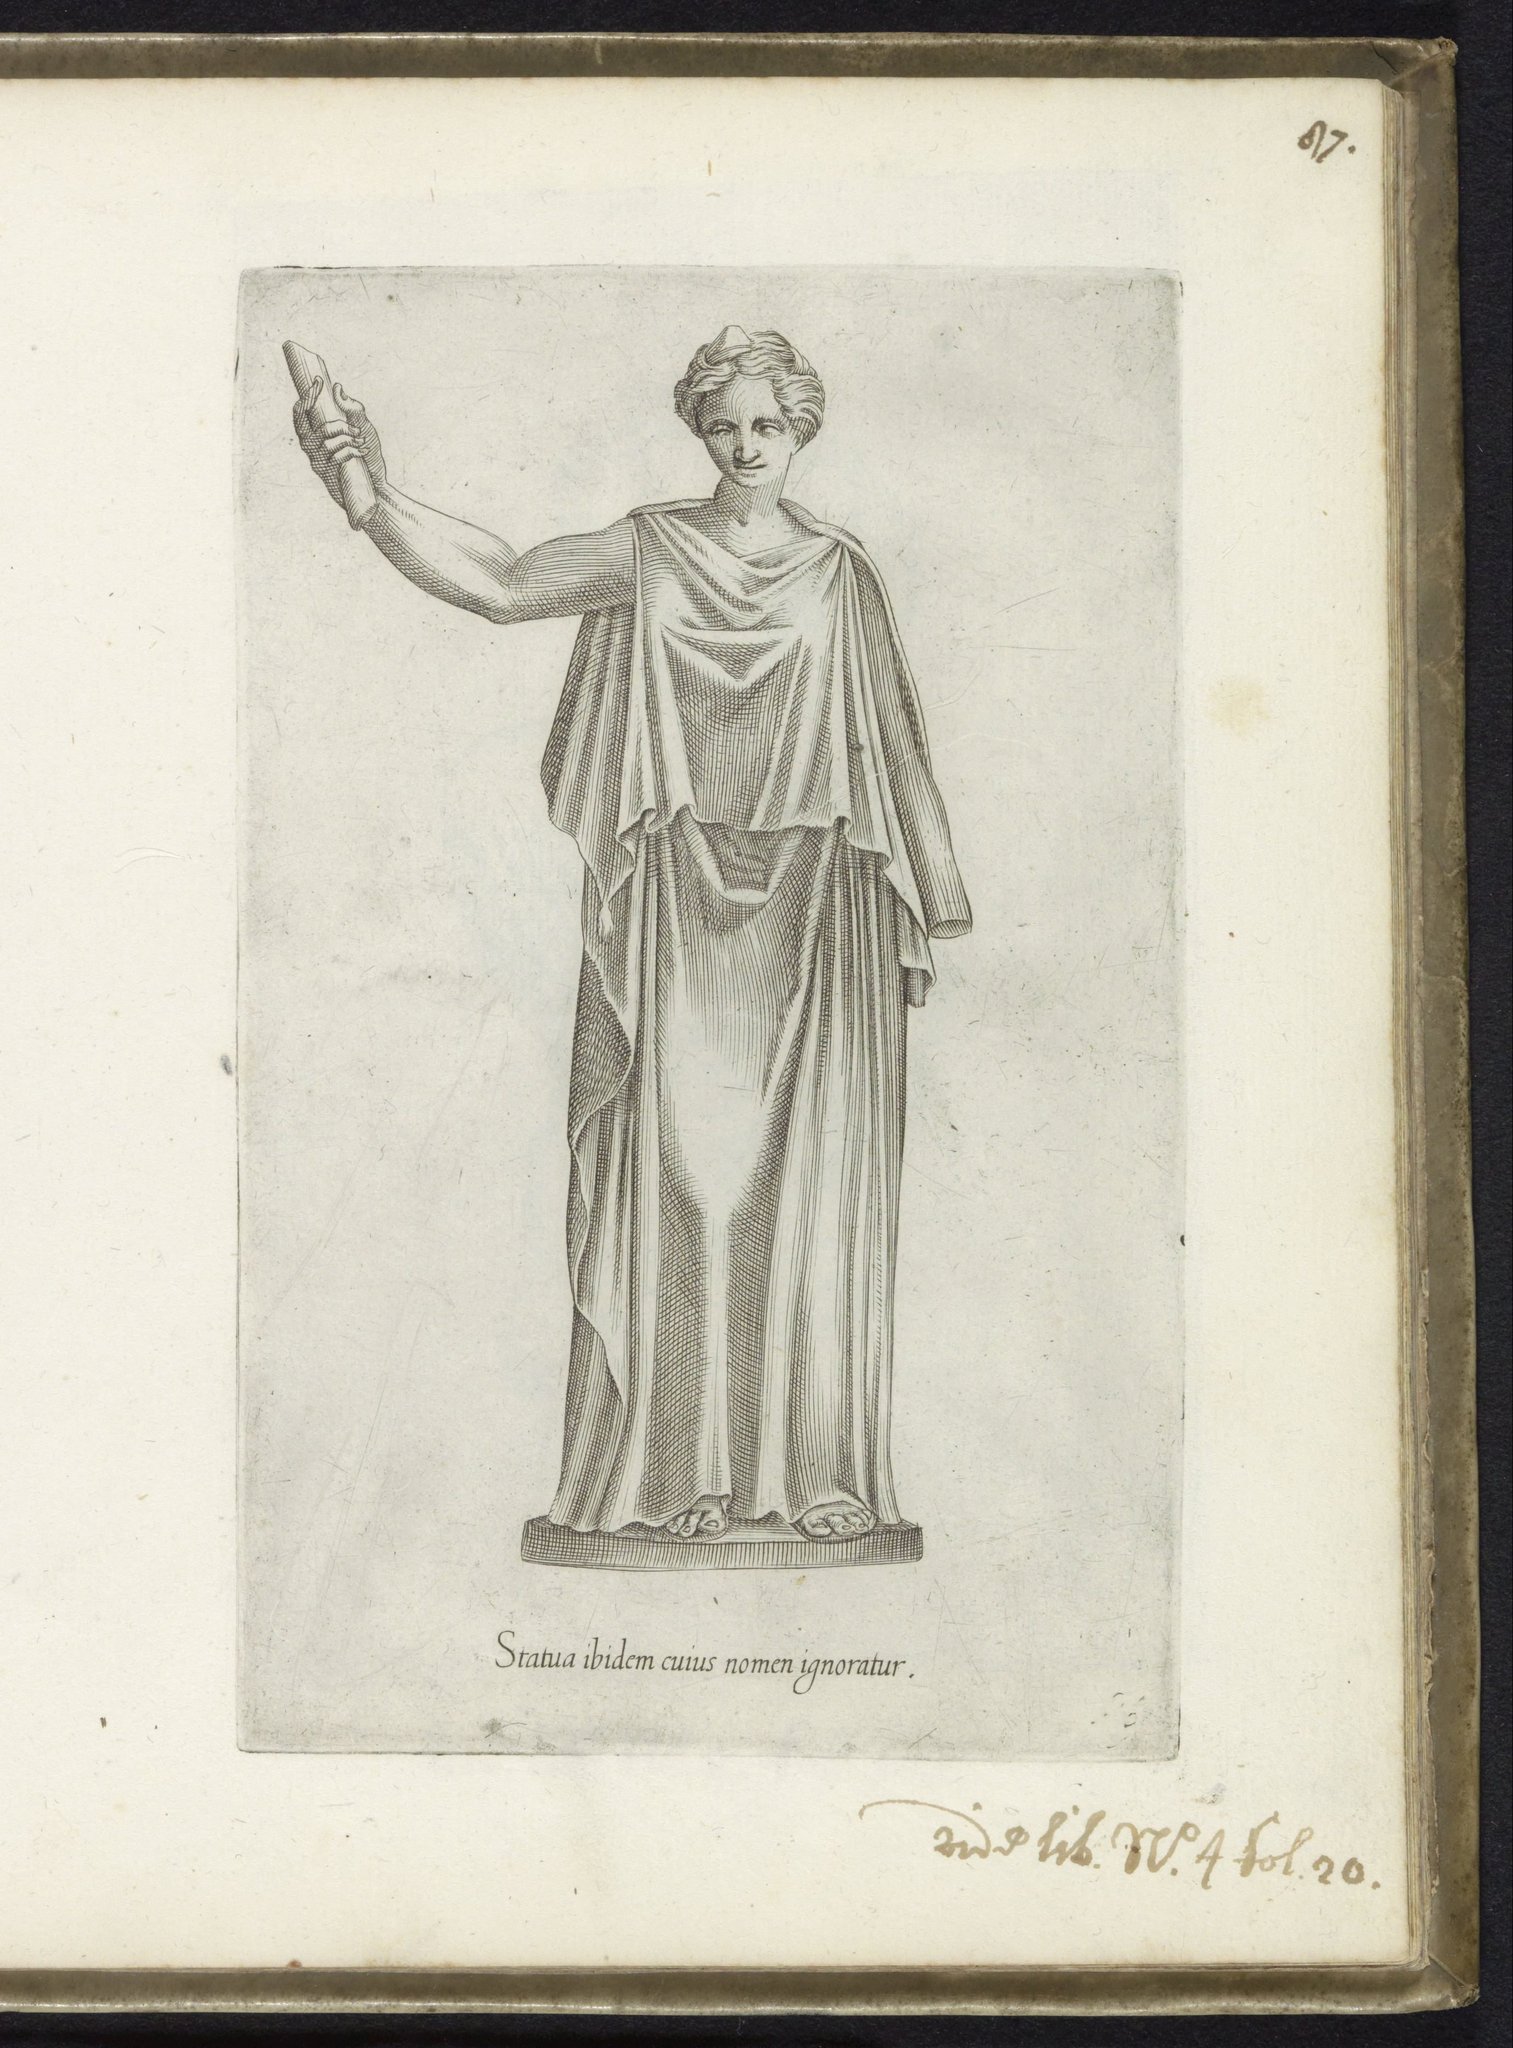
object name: album leaf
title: Sculpturen uit de oudheid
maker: Anonymous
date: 1600-1699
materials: paper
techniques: engraving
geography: italy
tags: adult woman, piece of sculpture, reproduction of a piece of sculpture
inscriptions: inscription: ‘Ende lib. No. 4 fol. 20.’, inscription: ‘Ende lib. No. 4 fol. 20. Ende lib. No. 2. fol. 105.’, number: ‘87’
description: Deze prent maakt deel uit van een reeks van ten minste 50 prenten van sculpturen uit de oudheid.